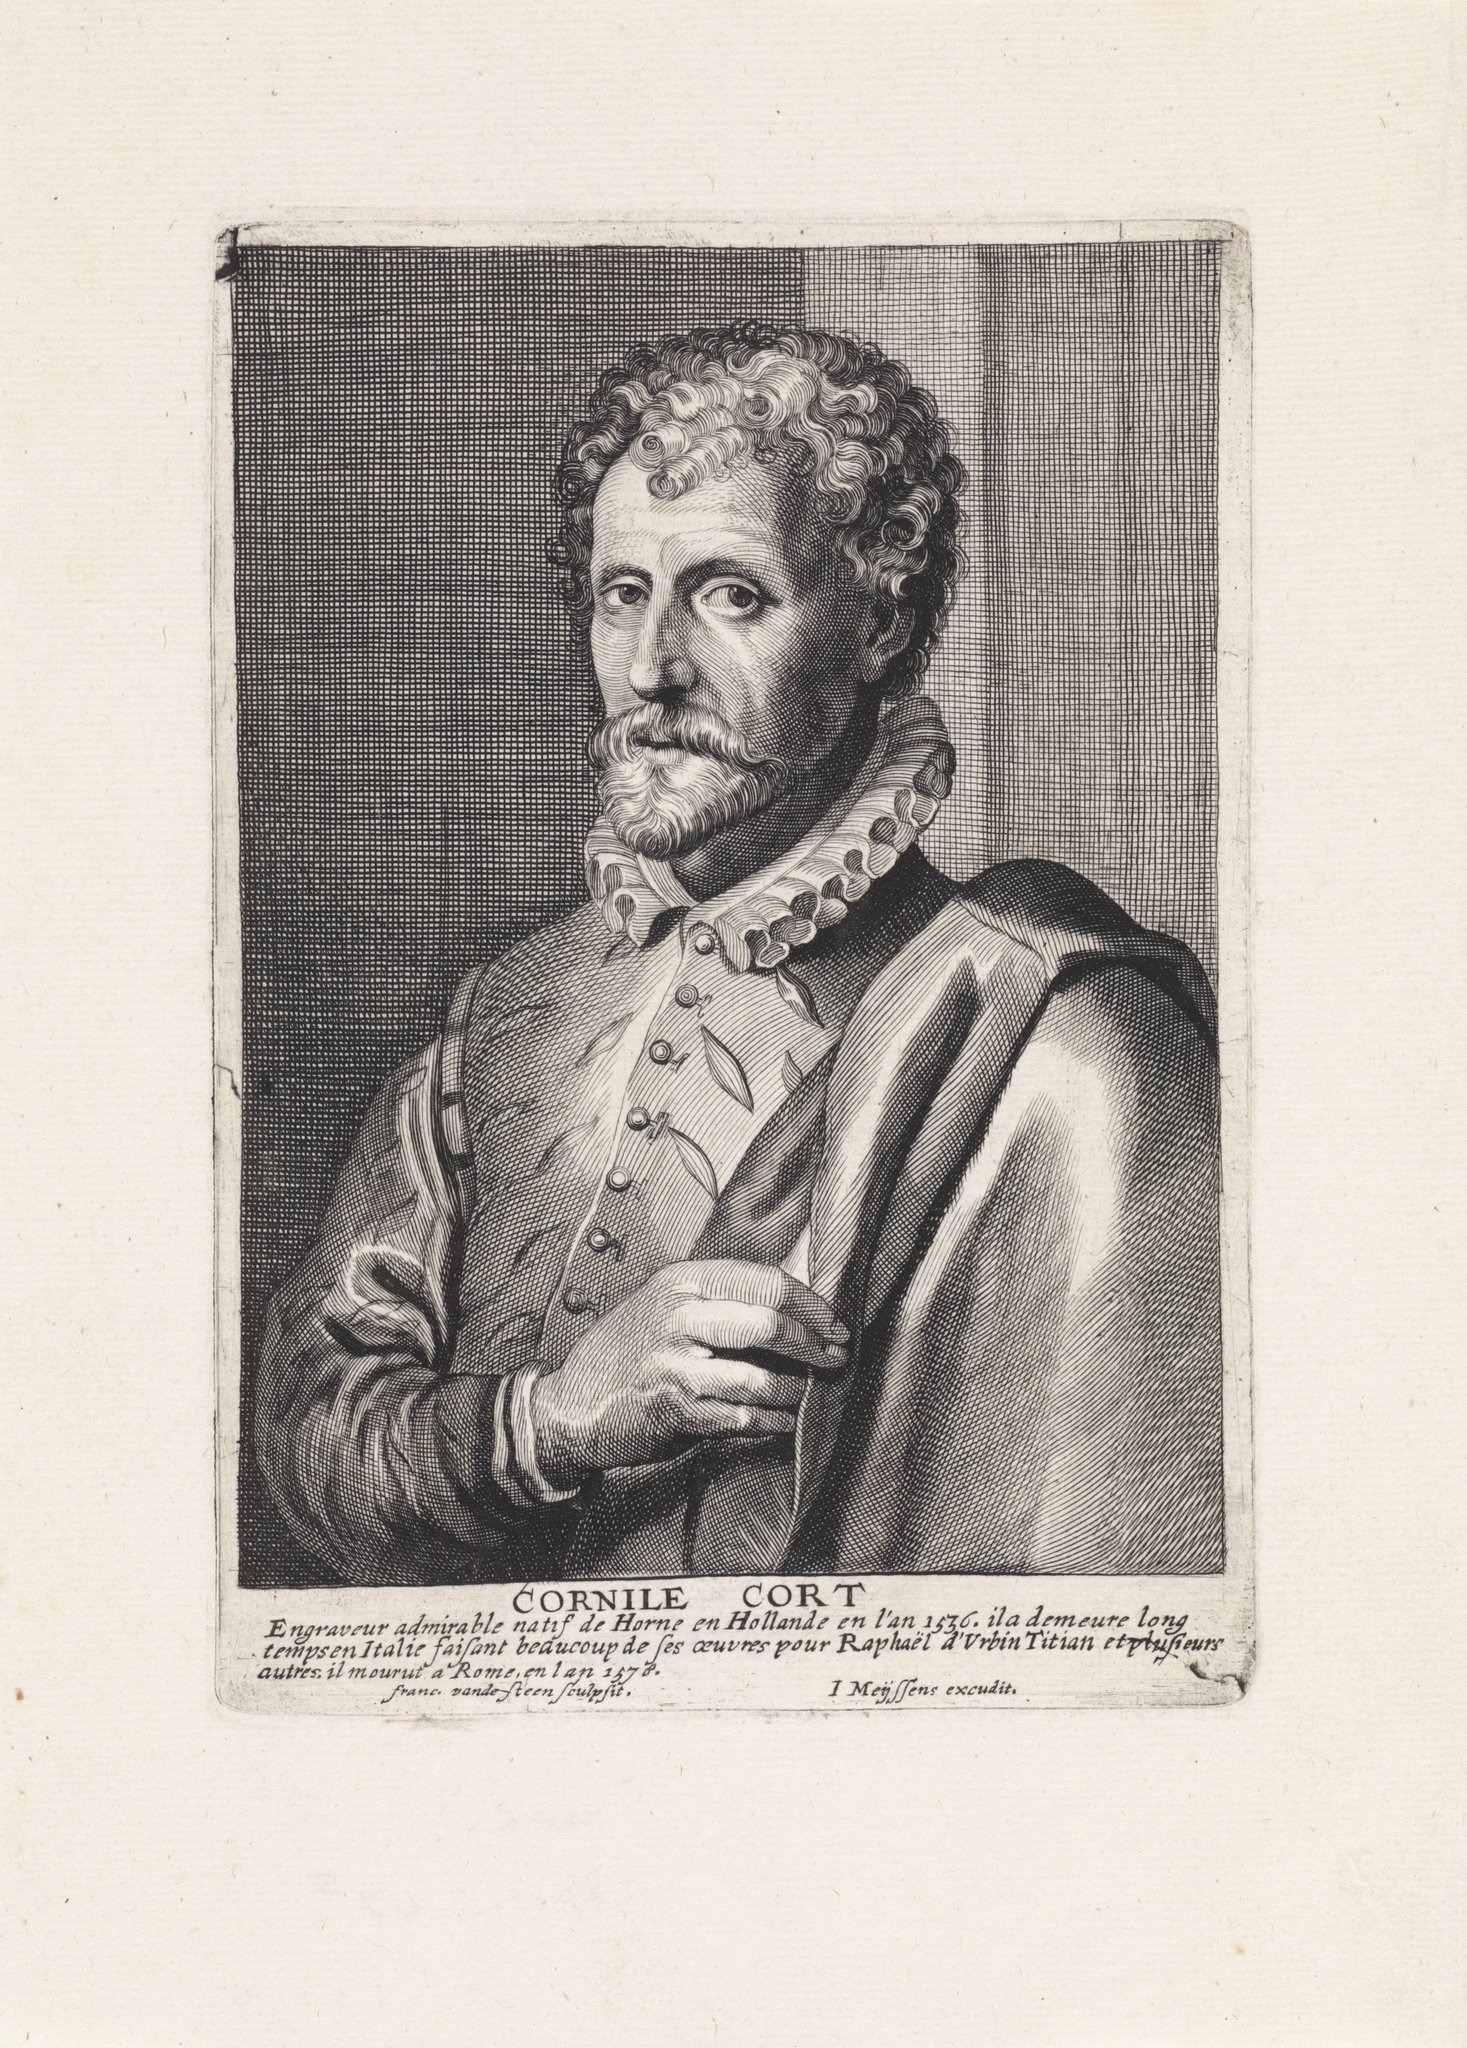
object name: print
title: Image de divers hommes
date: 1649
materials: paper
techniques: engraving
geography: antwerp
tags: rome, print maker, cornelis cort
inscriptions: collector's mark: Lugt 2228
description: Prent uit de serie: Image de divers hommes desprit sublime qui par leur art et science devront vivre eternellement et des quels la lovange et renommée faict estonner le monde, A Anvers mis en lumiere par Iean Meyssens peinctre et vendeur de lart au Cammestraet l'an .M.DC.XLIX. Antwerpen: Joannes Meyssens, 1649.